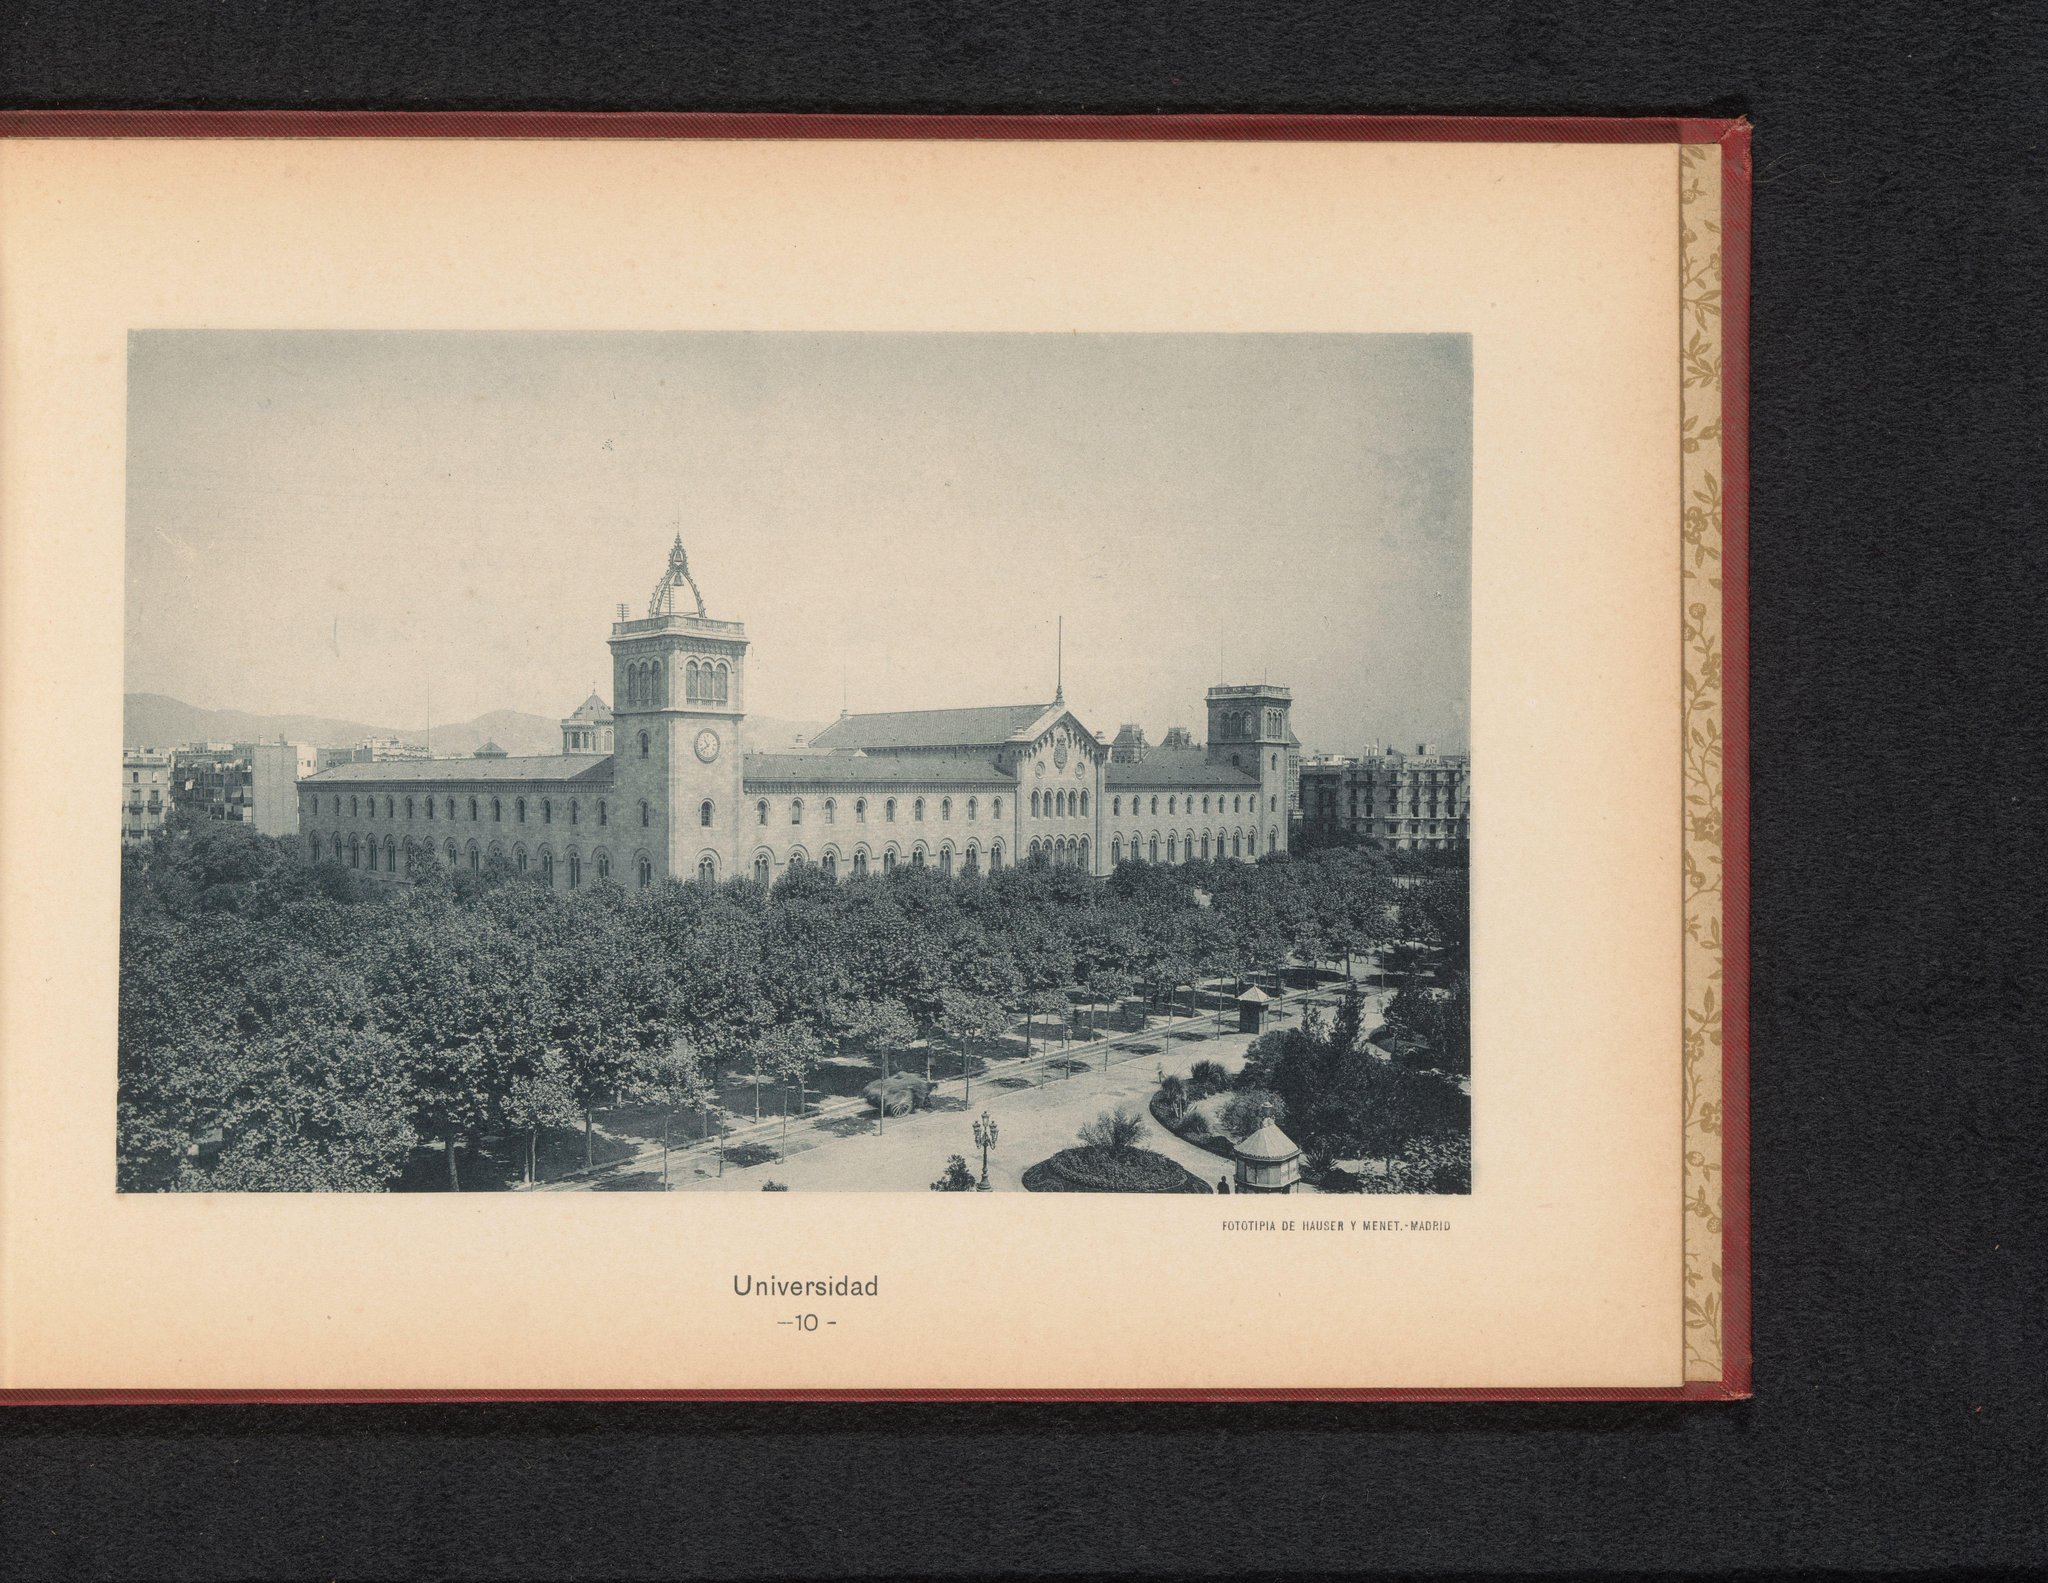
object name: photomechanical print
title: Universidad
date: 1880-1890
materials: paper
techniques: photograph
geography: barcelona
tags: university building, college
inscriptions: number: ‘-10-’